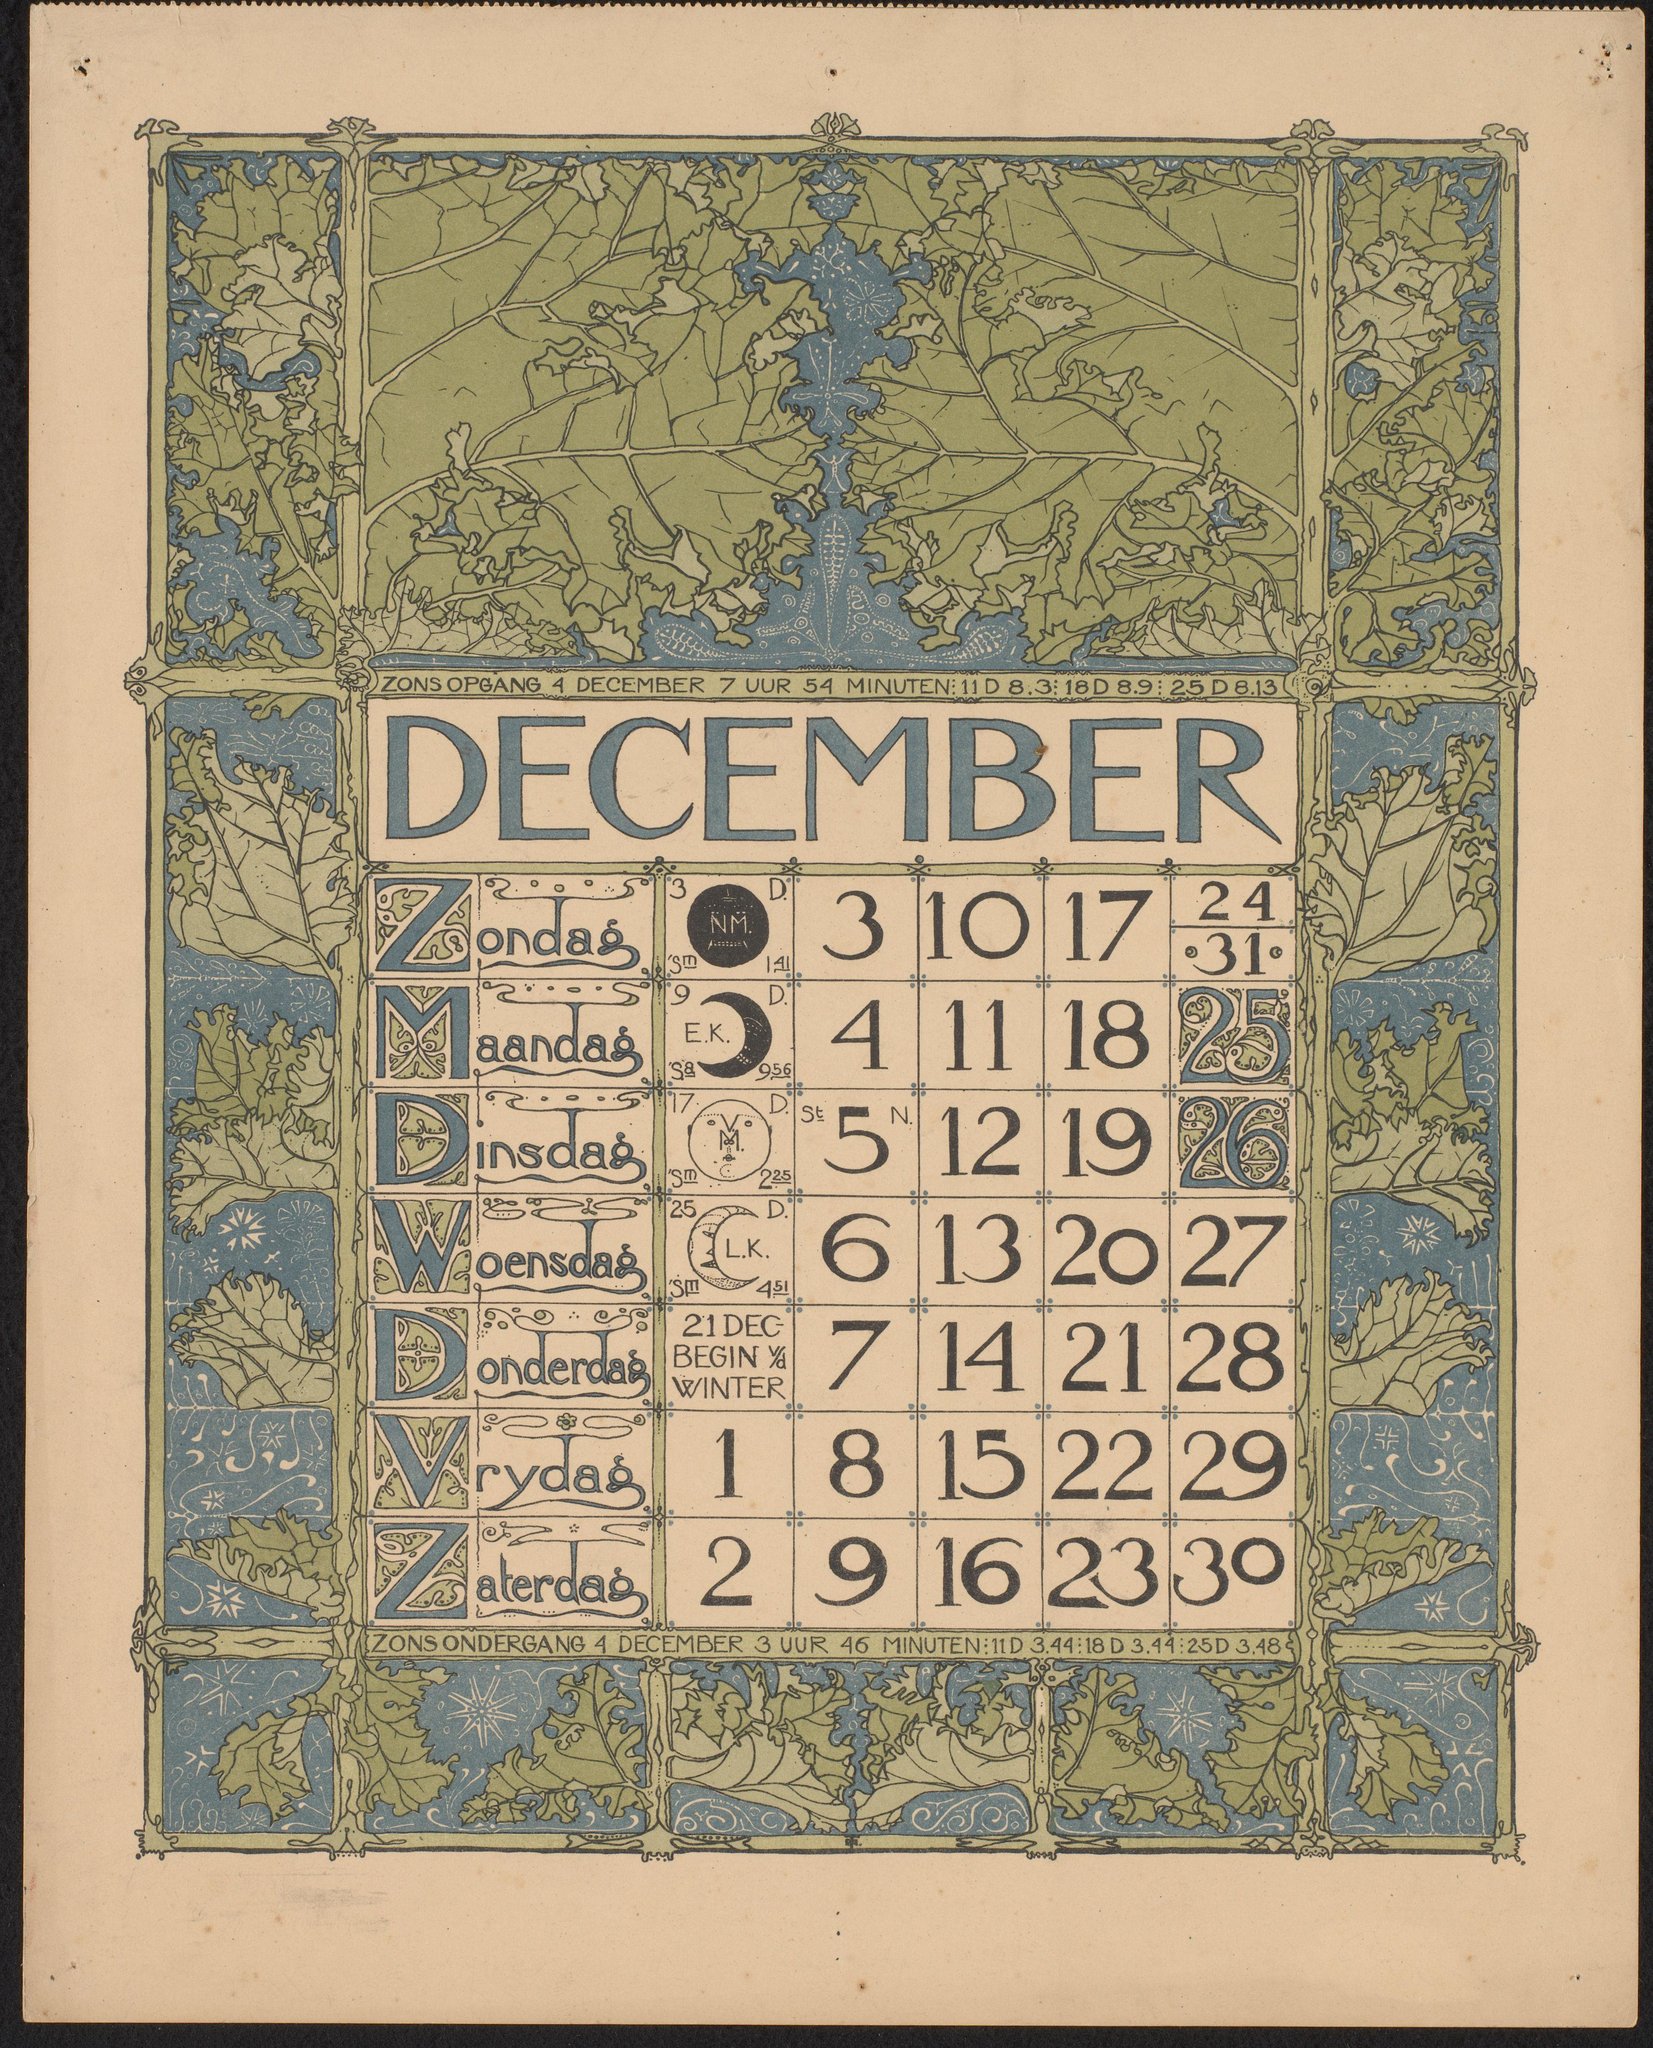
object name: print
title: Kalenderblad voor december 1899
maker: theo nieuwenhuis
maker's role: designer, draughtsman, print maker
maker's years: 1866-1951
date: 1898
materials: paper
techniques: lithograph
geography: amsterdam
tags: plants (in general), calendar, almanac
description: Randdecoratie van bladeren rond de maandkalender. Bovenrand geperforeerd waar dit kalenderblad verbonden was met de rest van het jaar.